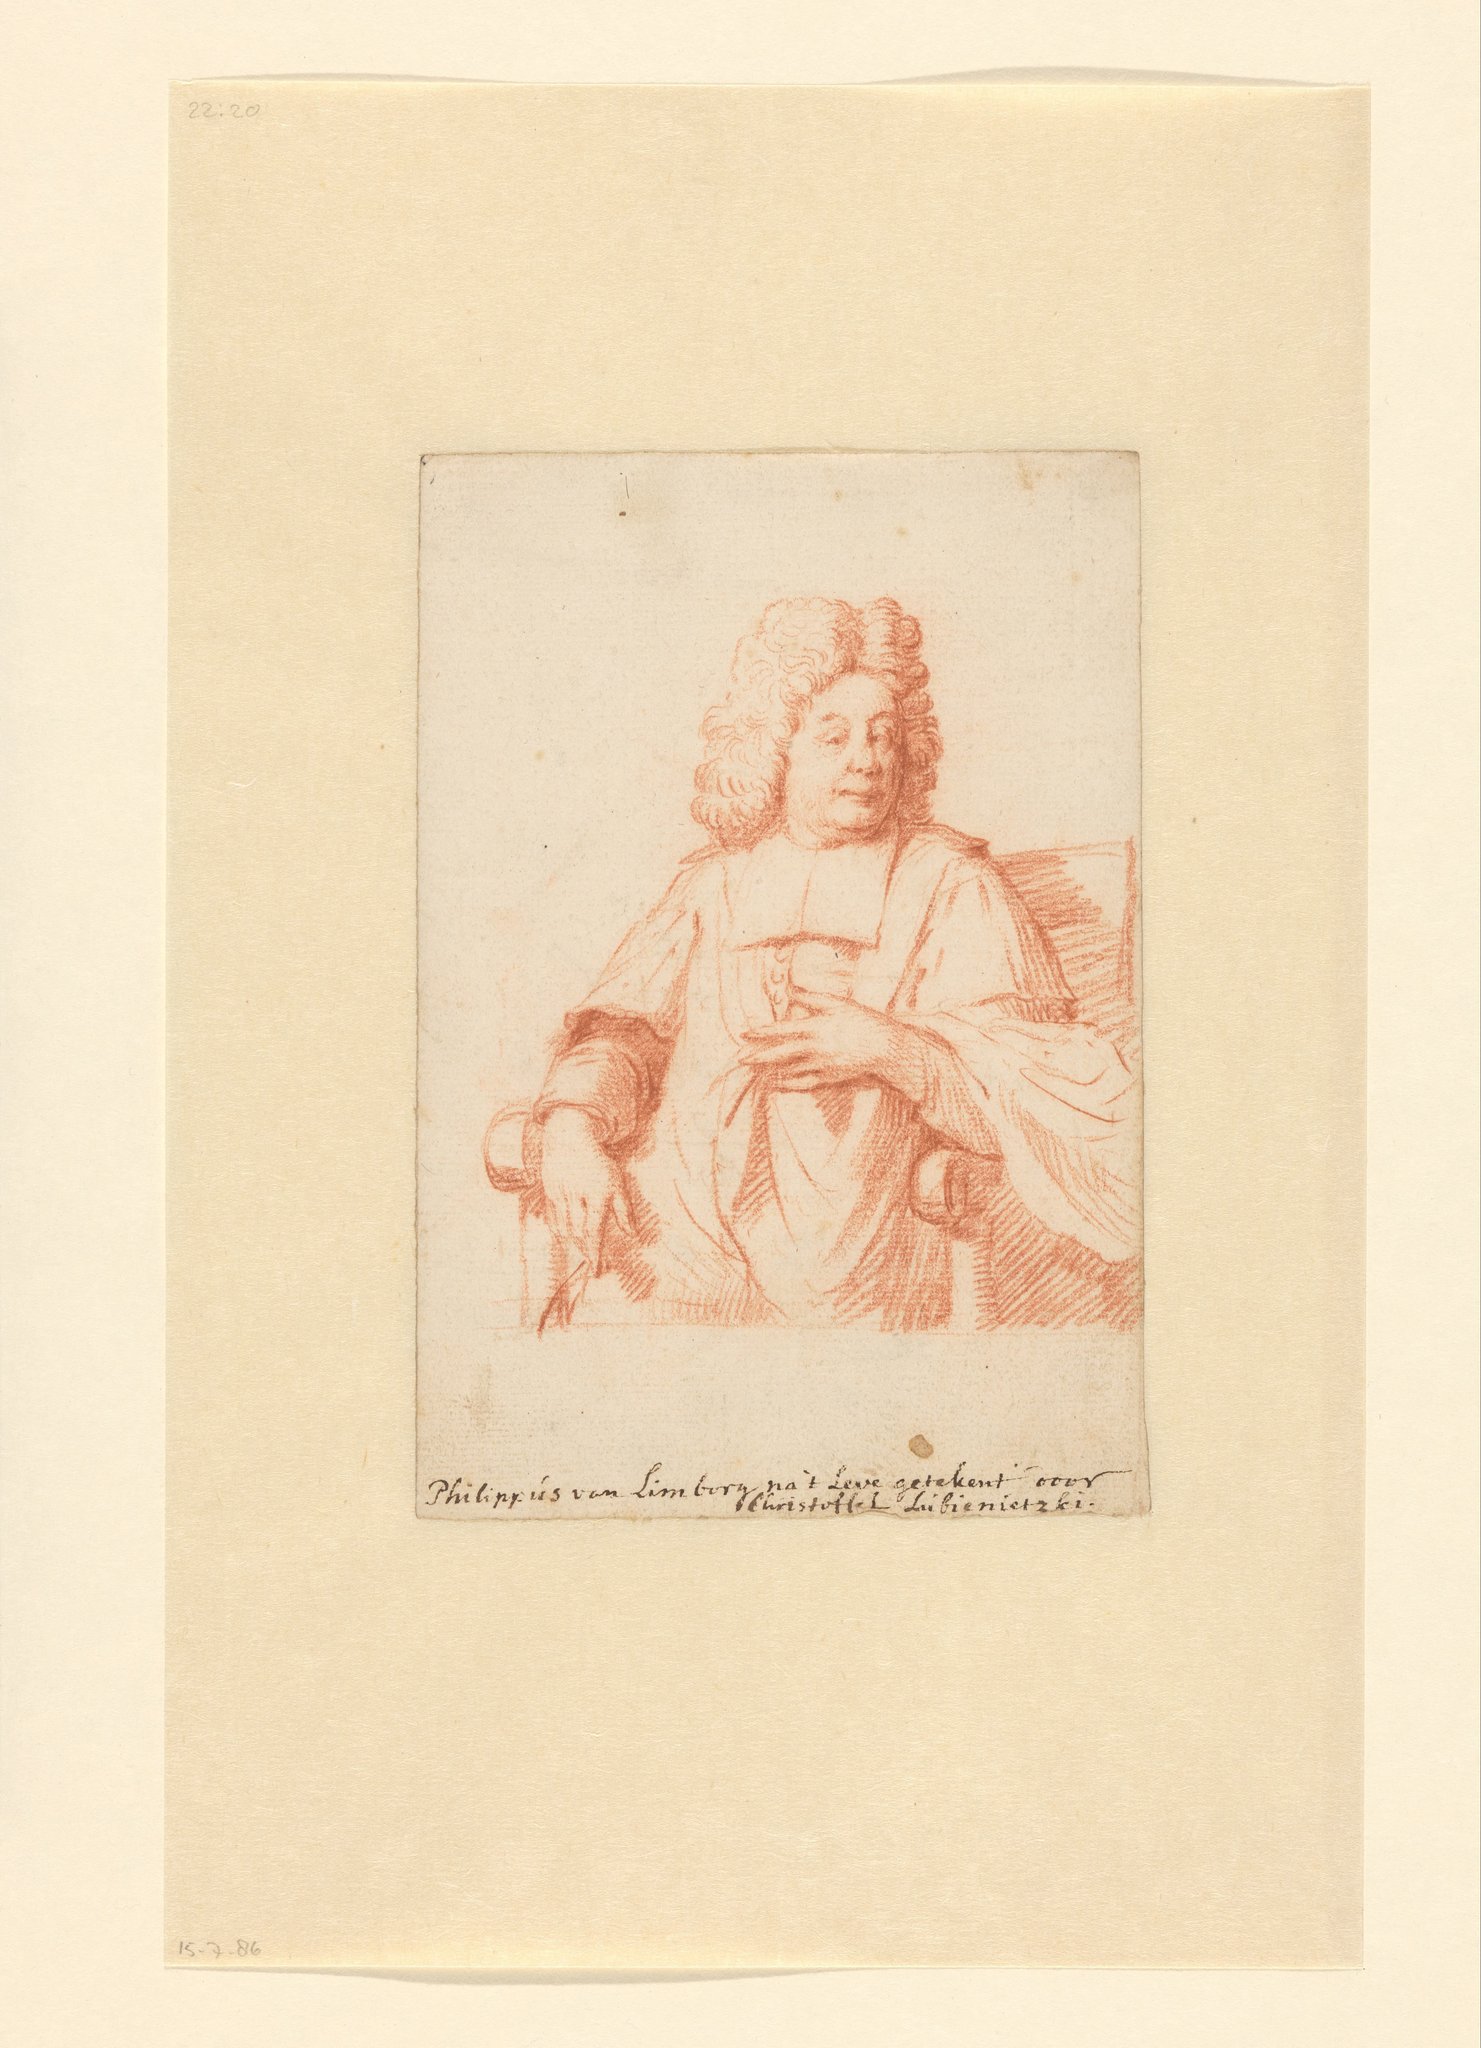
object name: drawing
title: Portret van Philippus van Limborch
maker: christoffel lubienitzki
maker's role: draughtsman, painter, print maker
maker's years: 1659-1729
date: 1680-1712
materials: chalk, ink, paper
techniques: pen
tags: amsterdam, historical persons